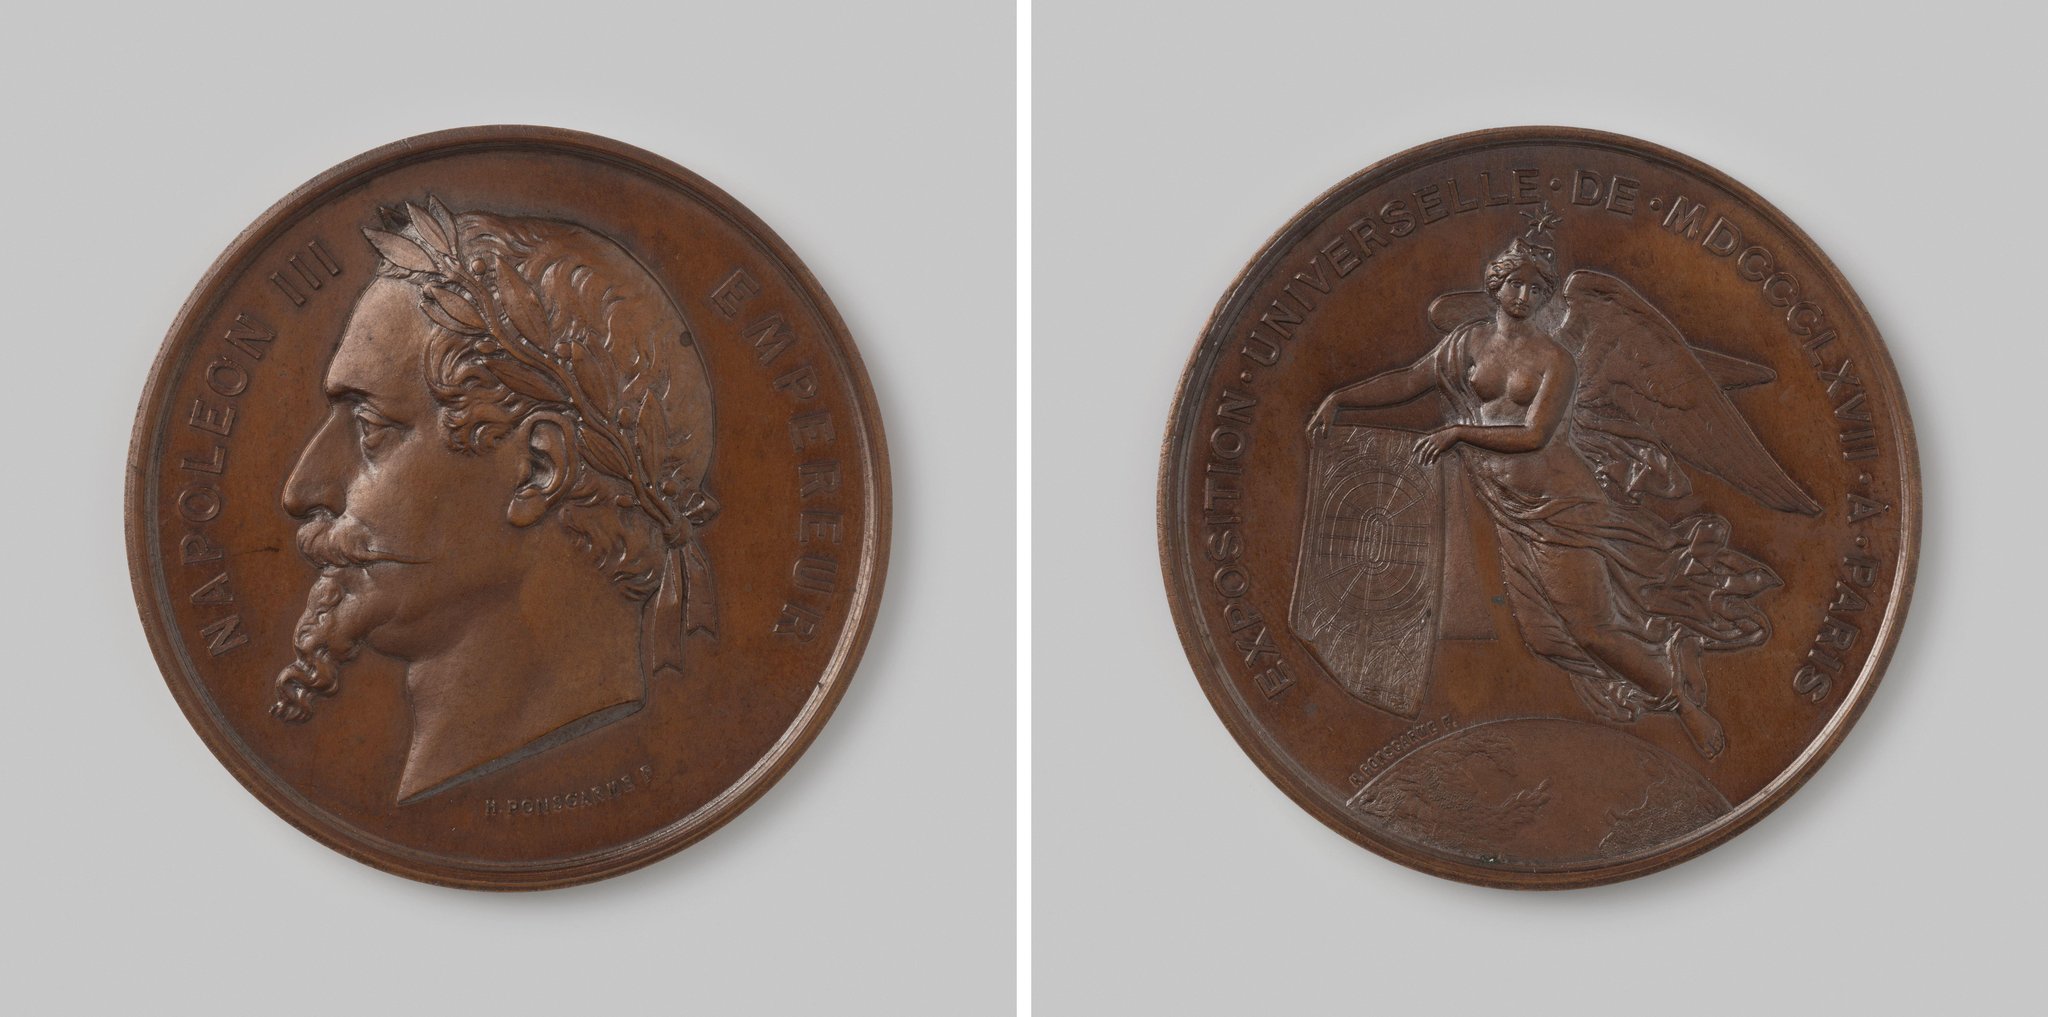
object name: history medal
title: Wereldtentoonstelling te Parijs 1867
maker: hubert ponscarme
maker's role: medailleur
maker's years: 1827-1903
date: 1867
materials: bronze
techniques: striking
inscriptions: hallmark: ‘(rozet) CUIVRE’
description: Bronzen penning, op de voorzijde het portret van Keizer Napoleon III naar links met omschrift, op de keerzijde een boven de aarde vliegende genius met een plattegrond van het expositieterrein, met omschrift.